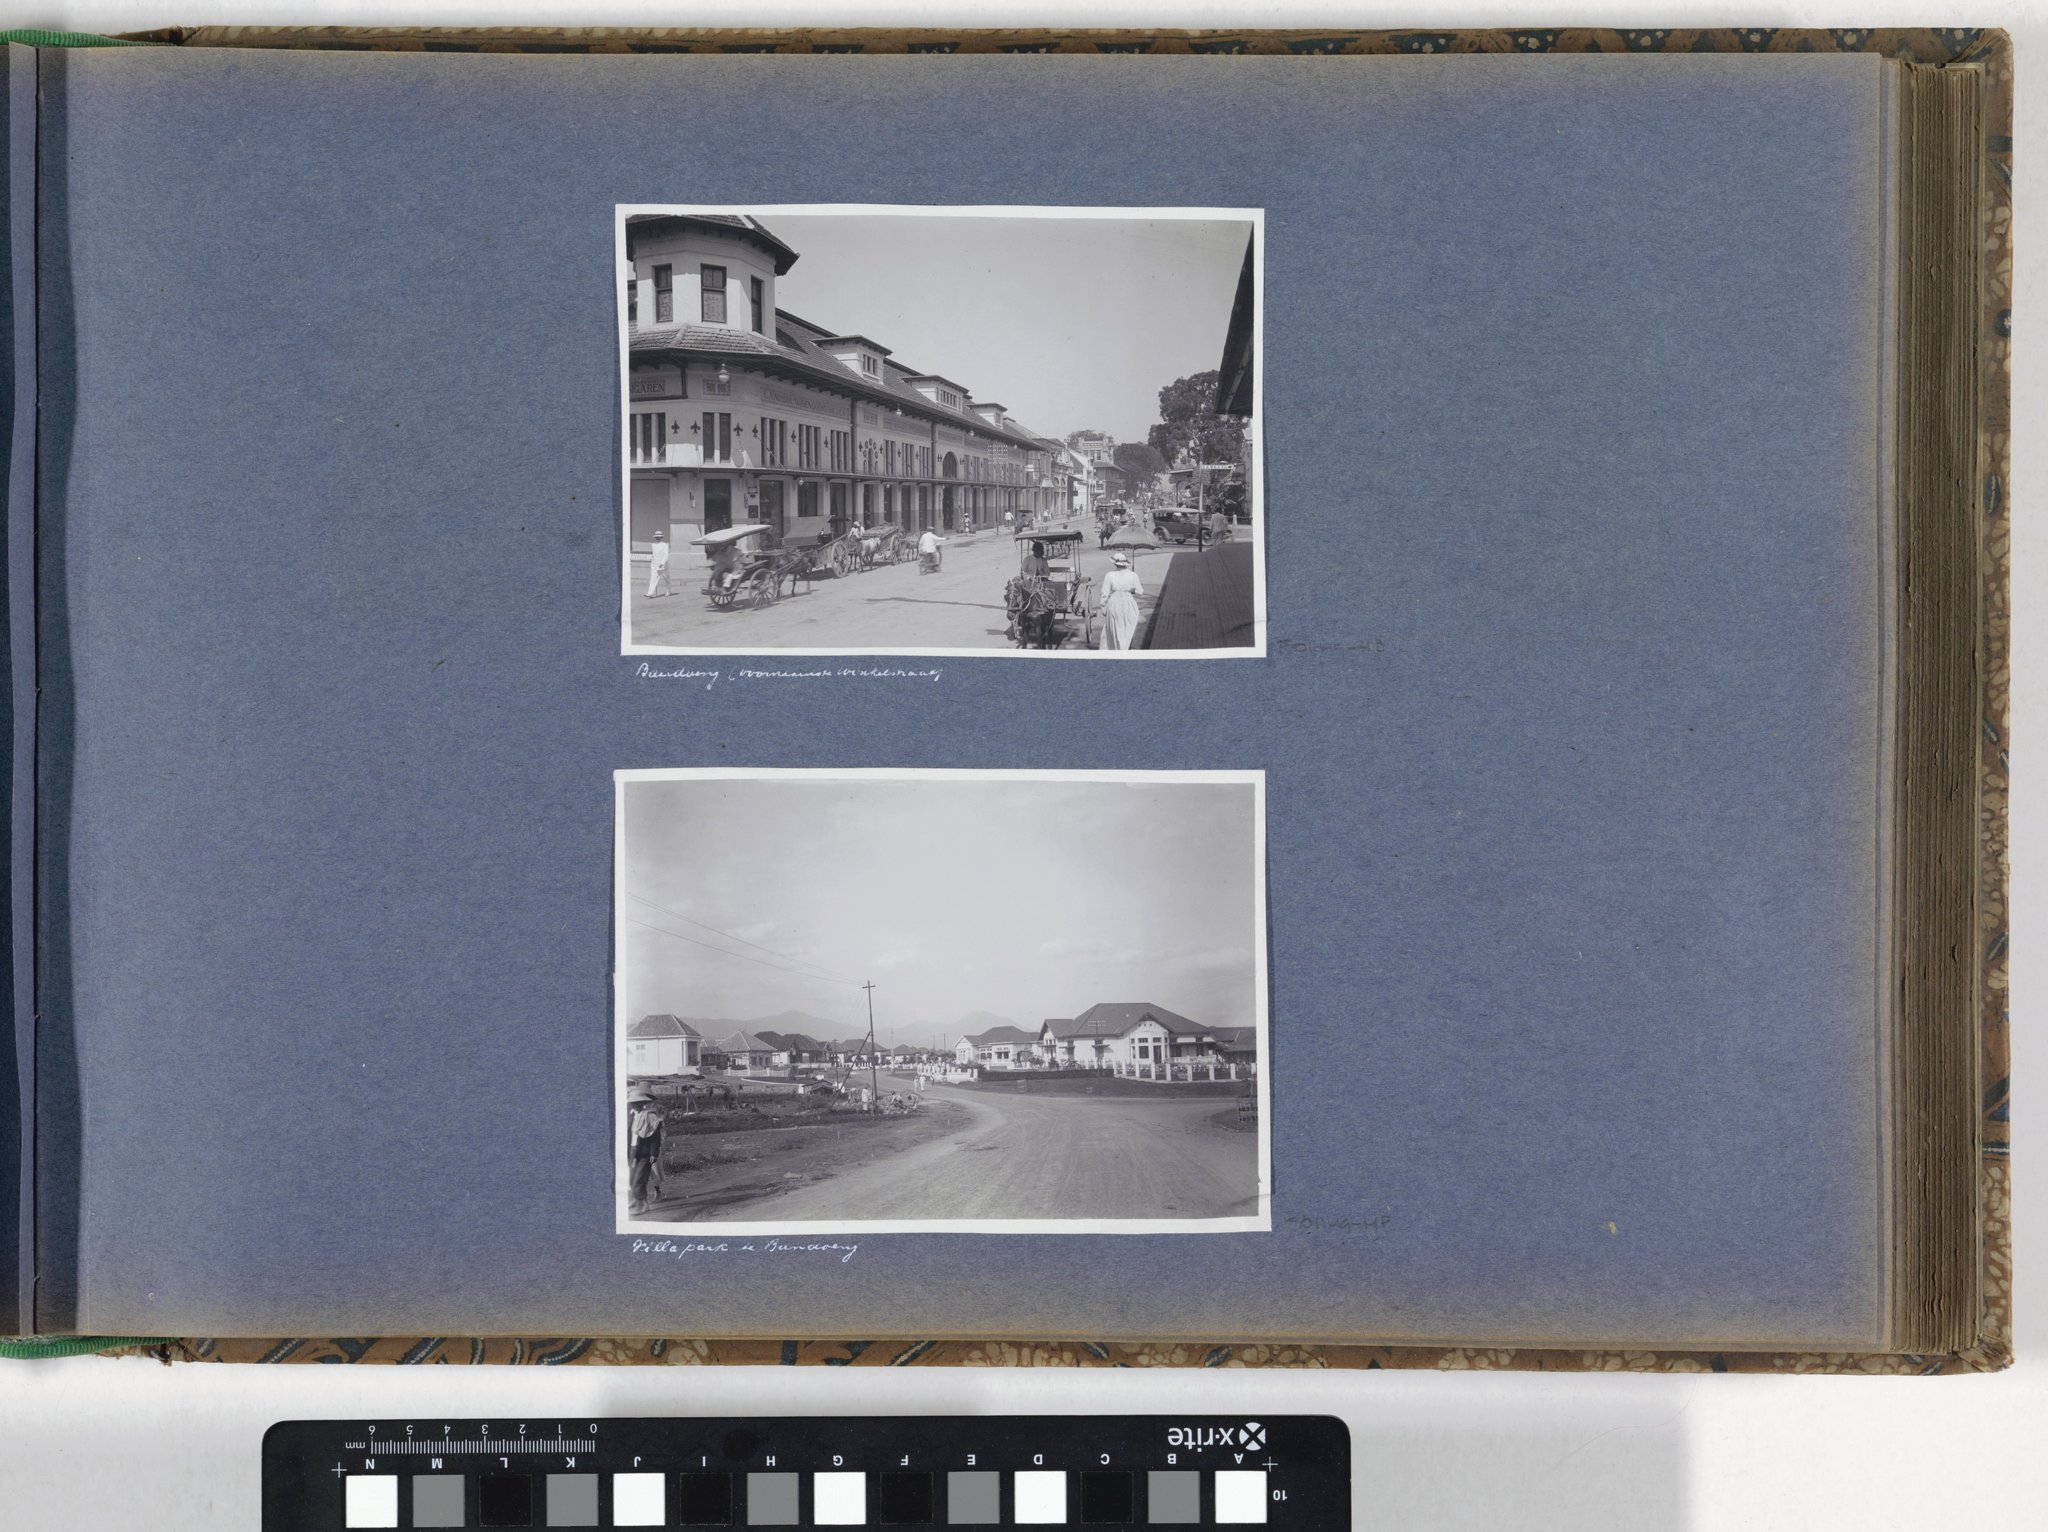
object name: photograph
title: Weg door een villawijk in Bandung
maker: Anonymous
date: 1900-1920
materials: paper, photographic support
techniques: gelatin silver print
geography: bandung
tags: rural housing, e.g. country-house, villa, cottage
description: Onderdeel van reisalbum met foto's van bedrijvigheid en bezienswaardigheden op Sumatra en Java en van de reis naar en van Nederlands-Indië.